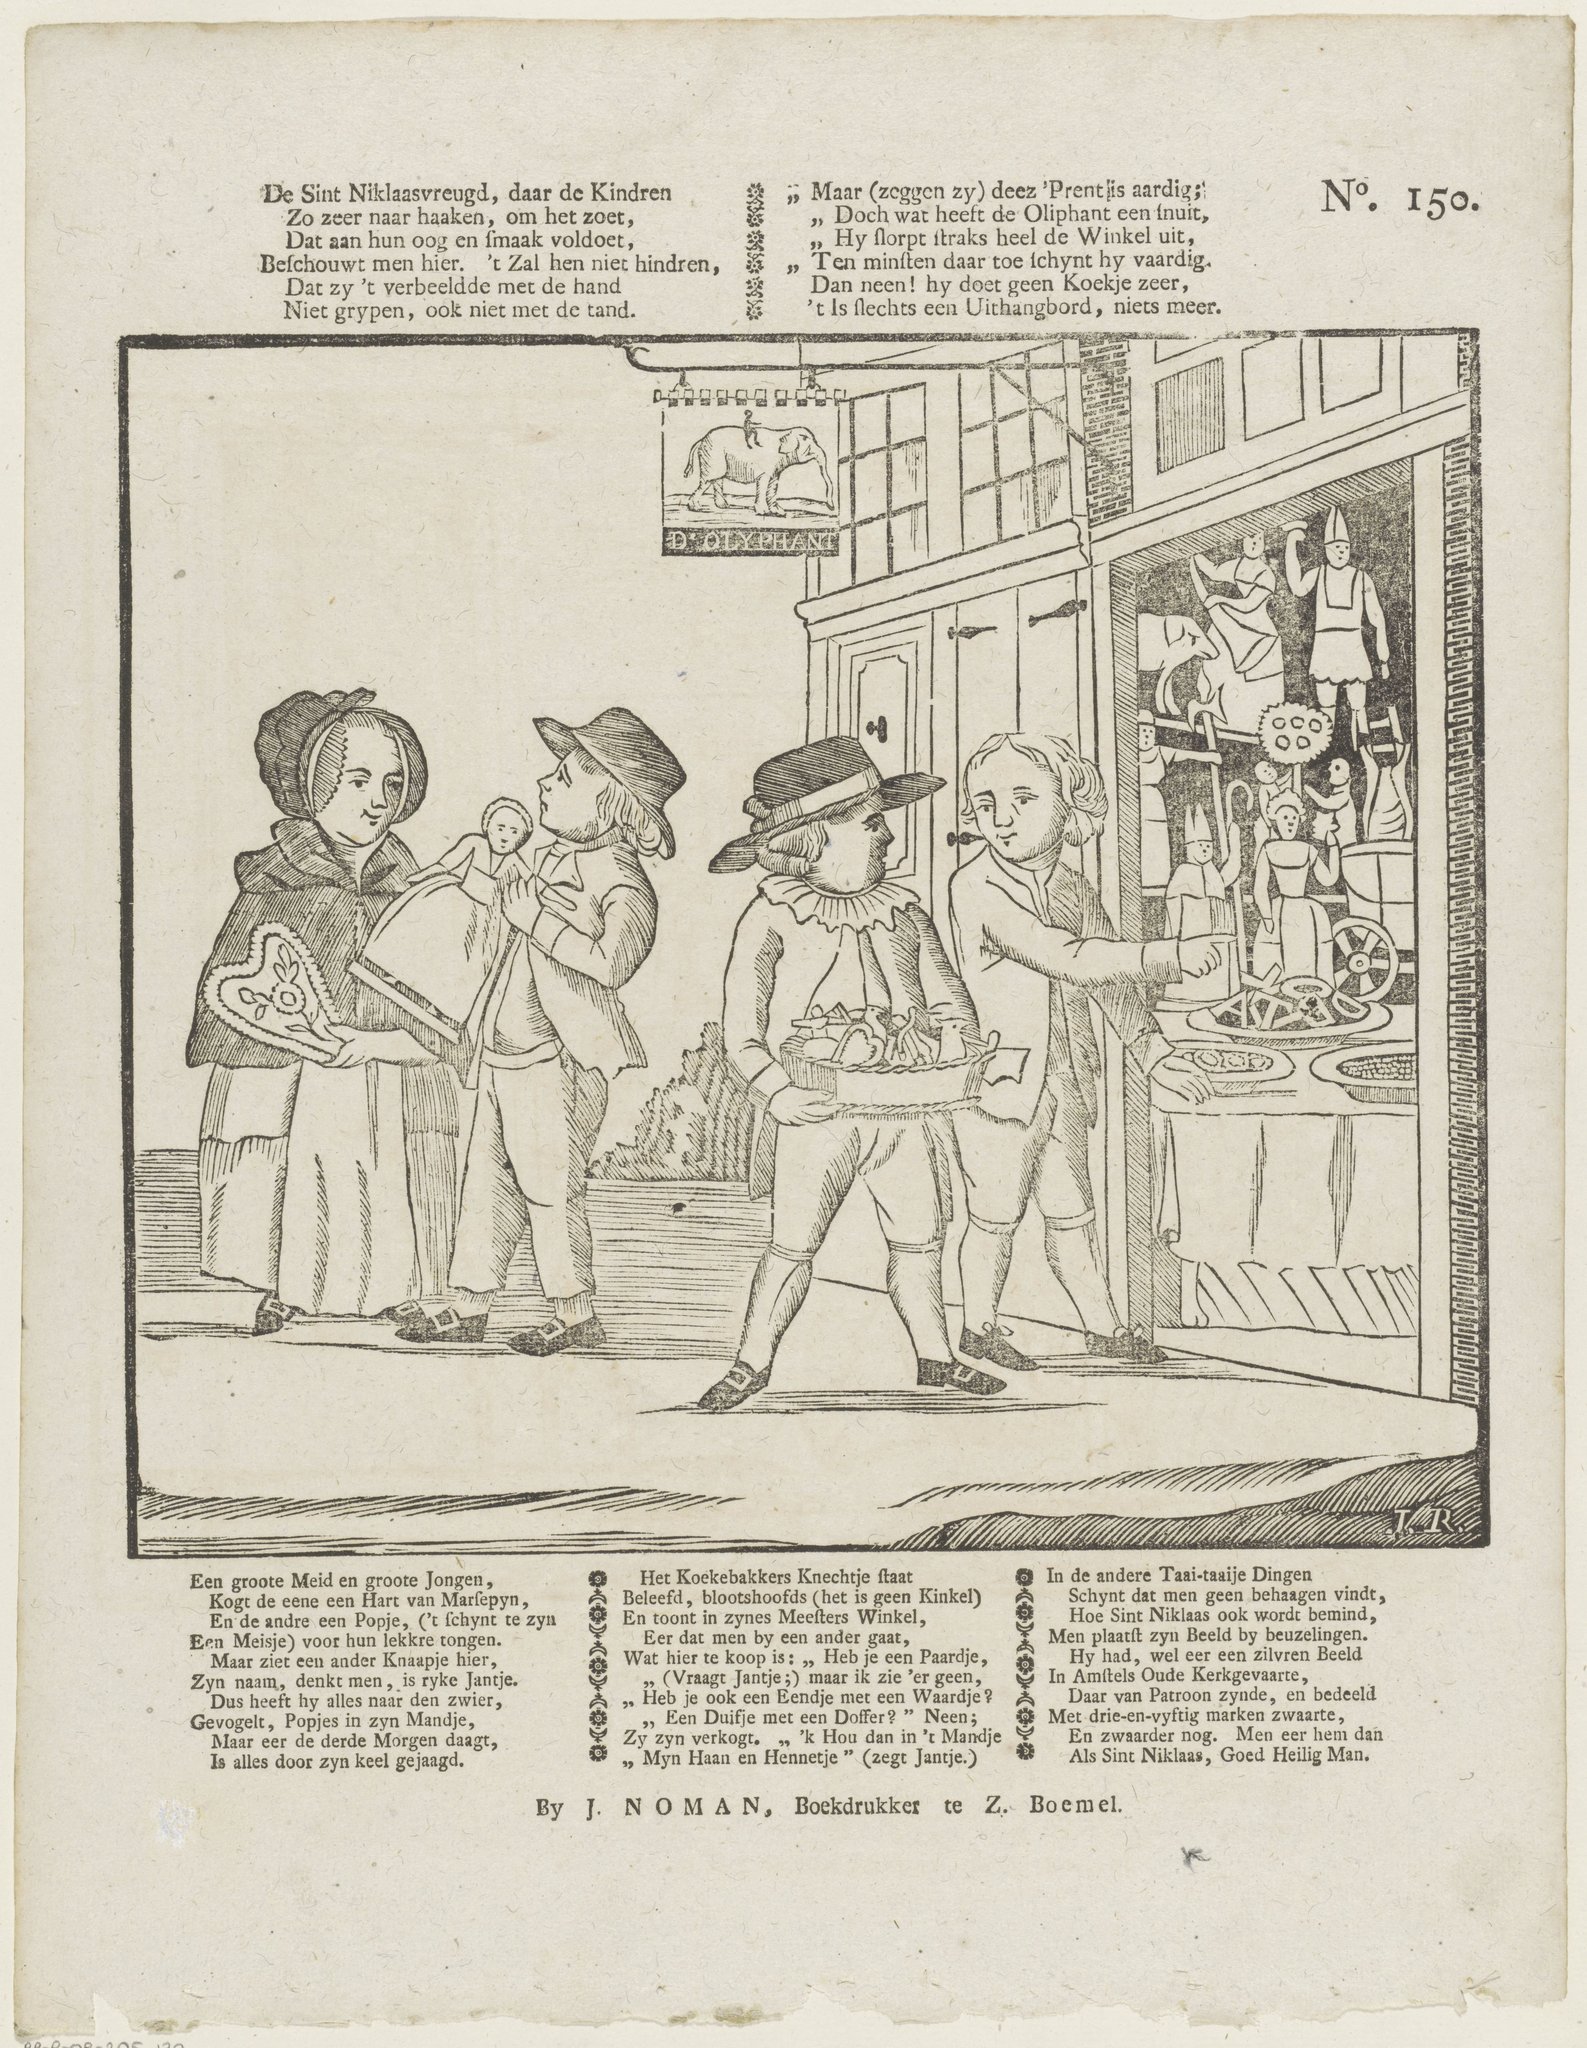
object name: popular print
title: De Sint Niklaasvreugd, daar de kindren / Zo zeer naar haaken, om het zoet [(...)]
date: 1806-1830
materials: paper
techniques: letterpress printing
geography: amsterdam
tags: the bishop nicholas of myra (or bari); possible attributes: anchor, boat, three golden balls (on a book), three purses, three children in a tub, three maidens, child, sugar-candy, (playing with) toys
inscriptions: collector's mark: Lugt 2760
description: Blad met een grote voorstelling van kinderen voor een winkel waar snoepgoed en speelgoed voor het Sinterklaasfeest verkocht wordt. Onder de afbeelding een vers in drie kolommen. Genummerd rechtsboven: No 150.